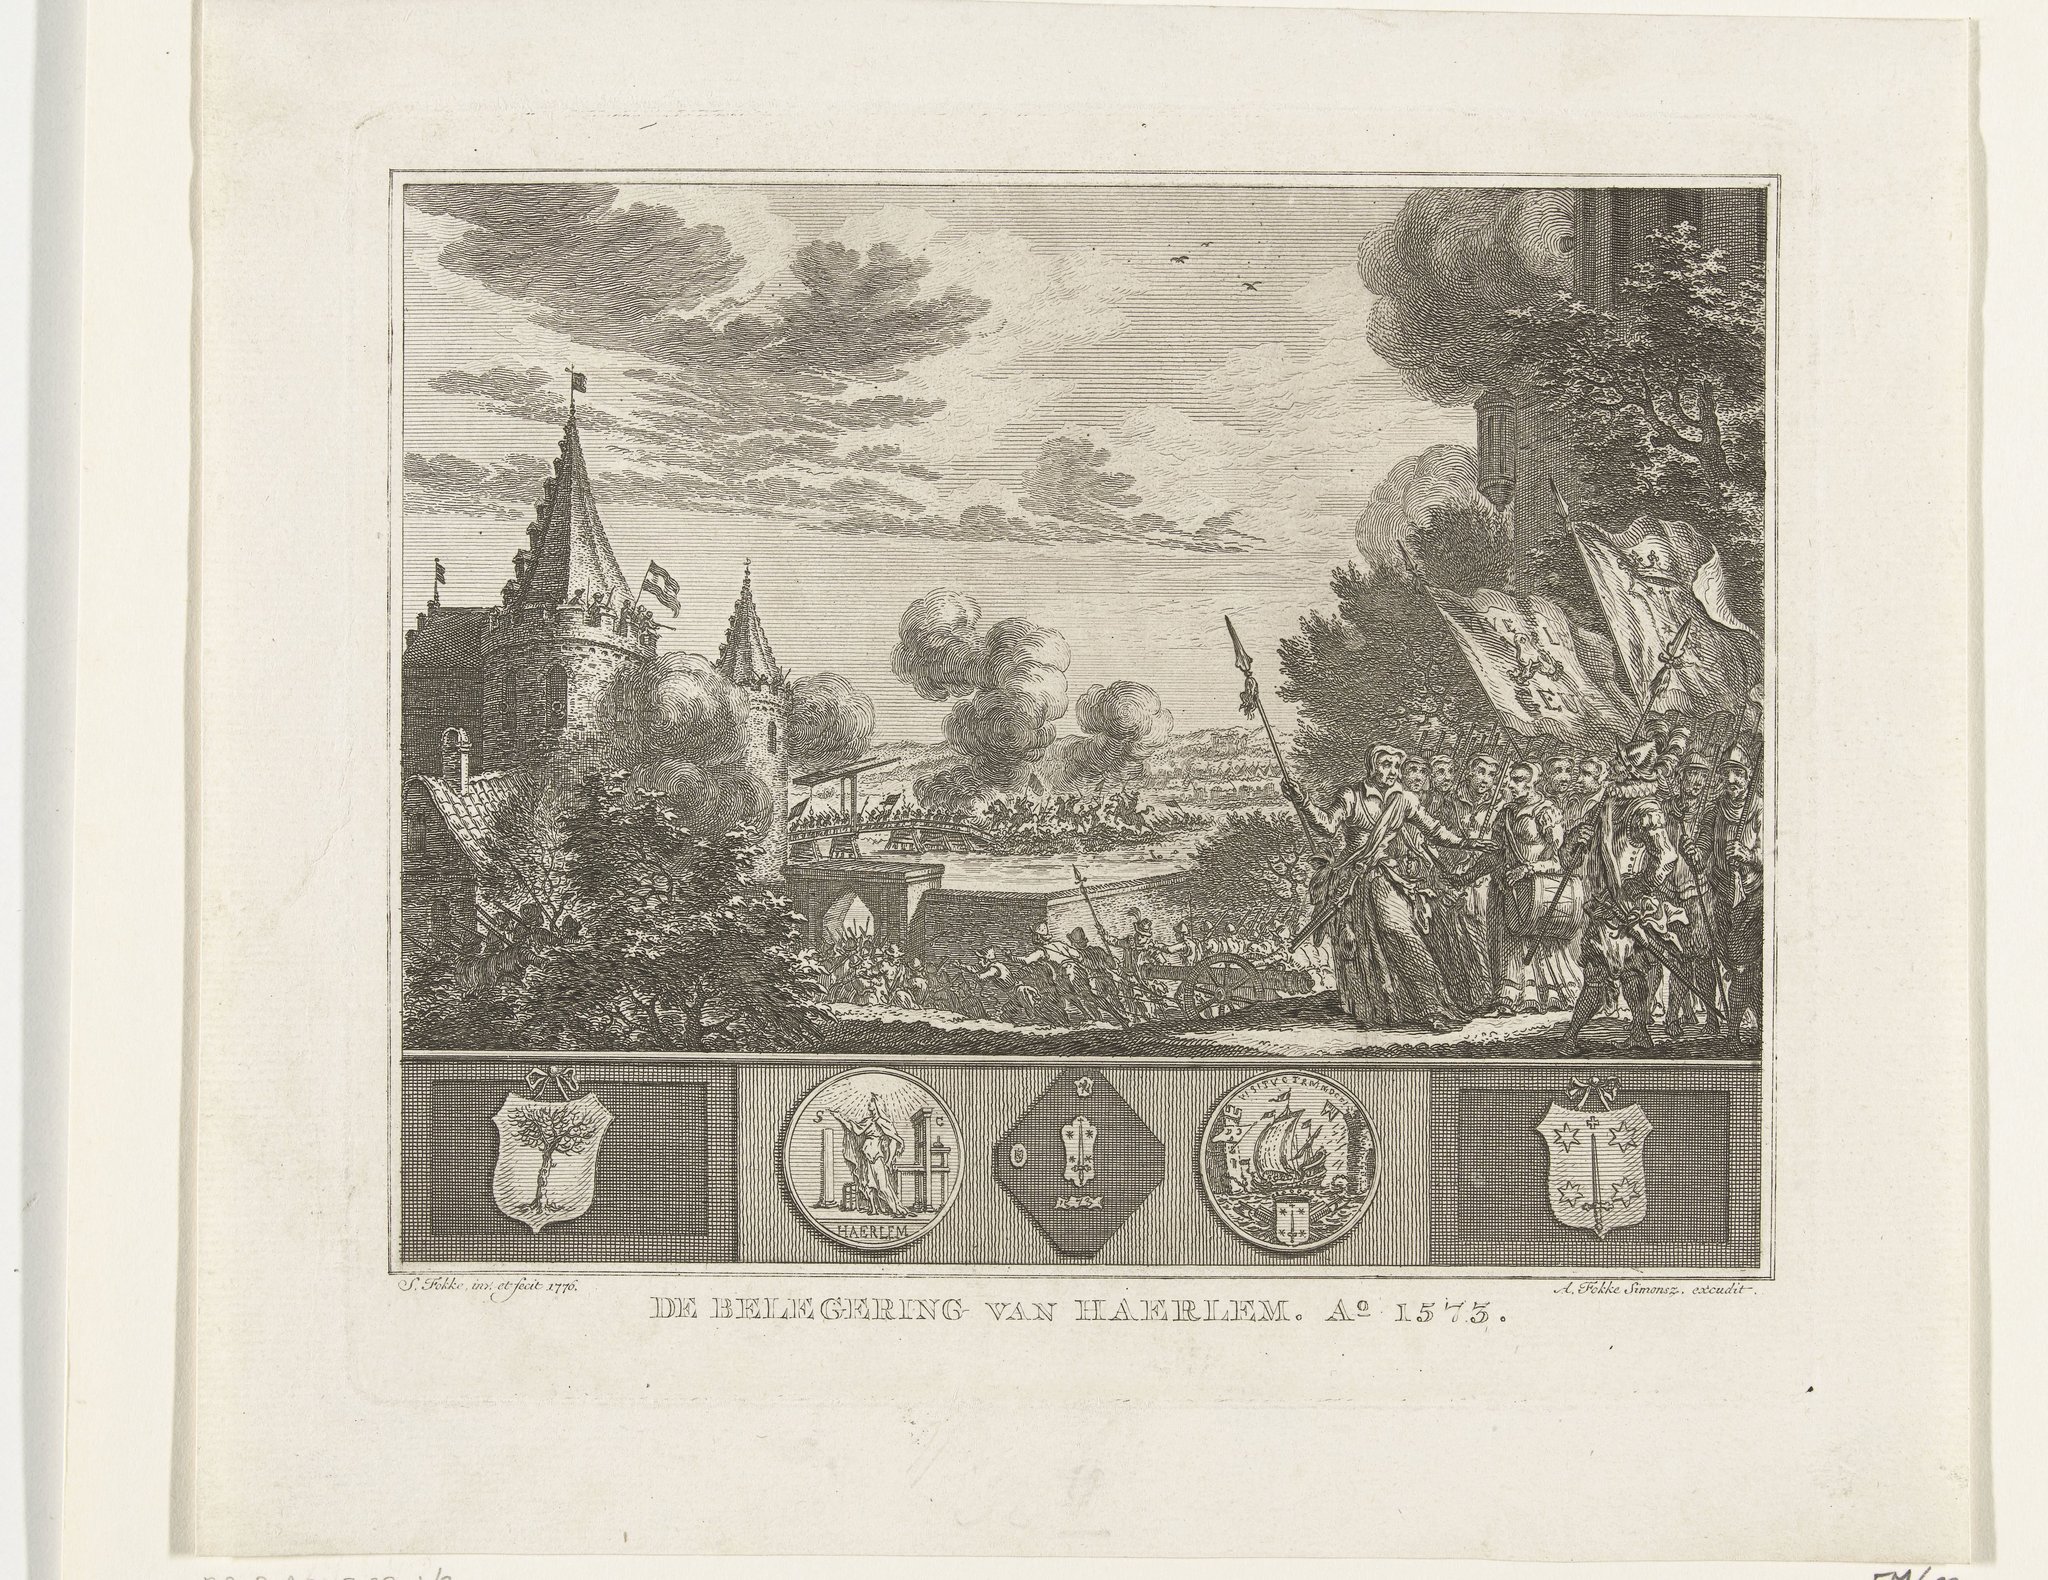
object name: print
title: De belegering van Haerlem. Ao. 1573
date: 1776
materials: paper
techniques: etching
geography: northern netherlands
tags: siege, position war, haarlem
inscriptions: date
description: Kenau Simonsdochter Hasselaer voert een vendel vrouwen aan, tegen een achtergrond met het beleg van Haarlem, 1573. Hieronder een strook met de wapens van Hasselaer en Haarlem, een noodmunt en vroedschapspenning.